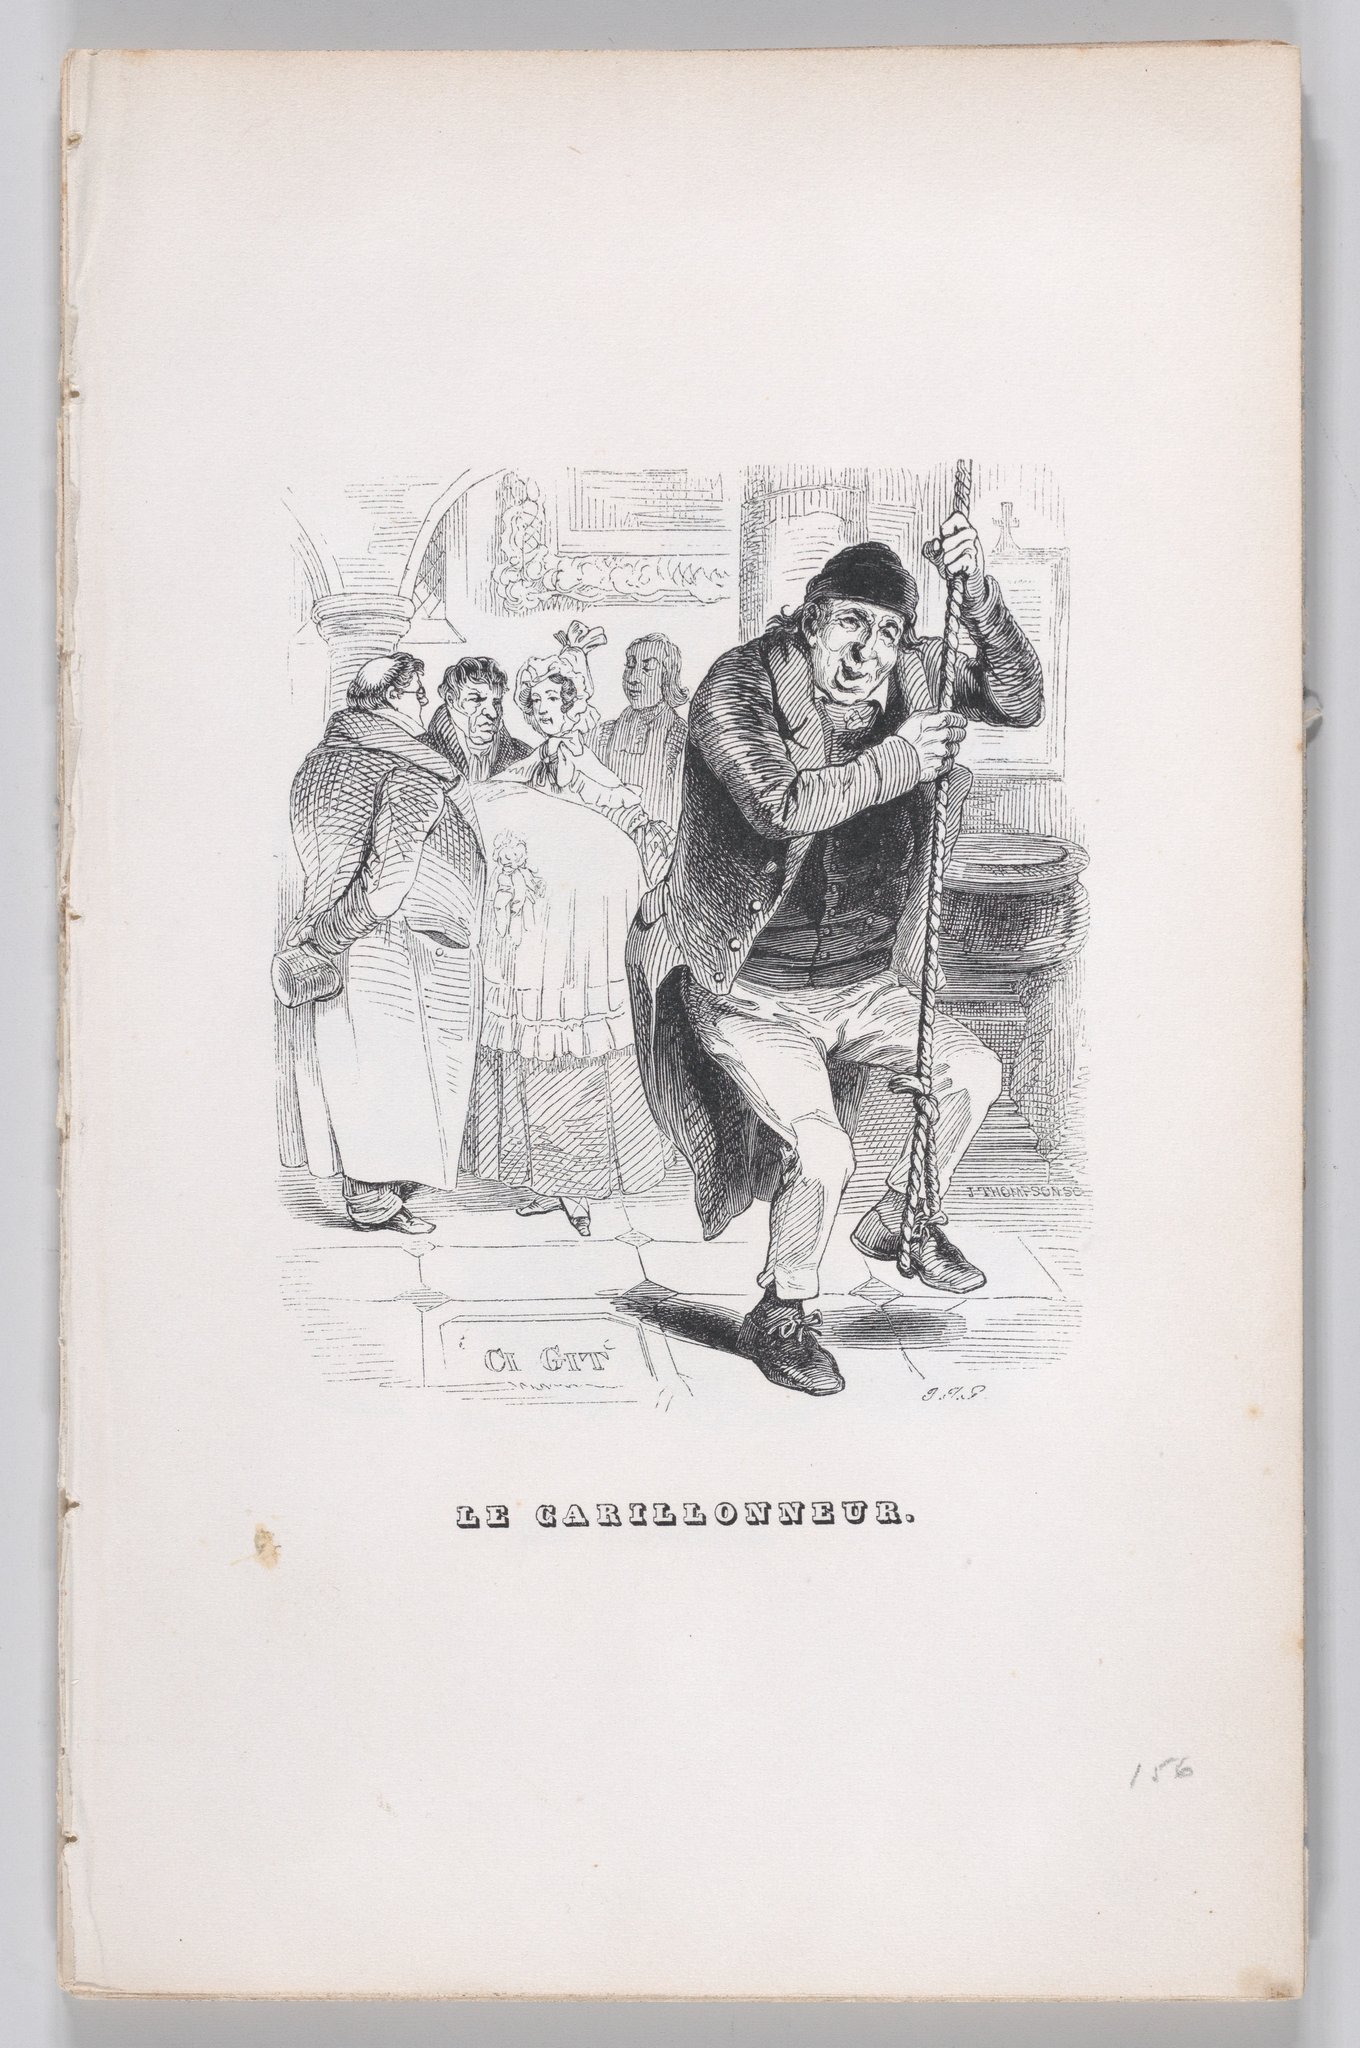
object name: print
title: The Bell Ringer, from "The Complete Works of Béranger"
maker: j. j. grandville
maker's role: illustrator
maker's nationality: french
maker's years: 1803-1847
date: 1836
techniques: engraving